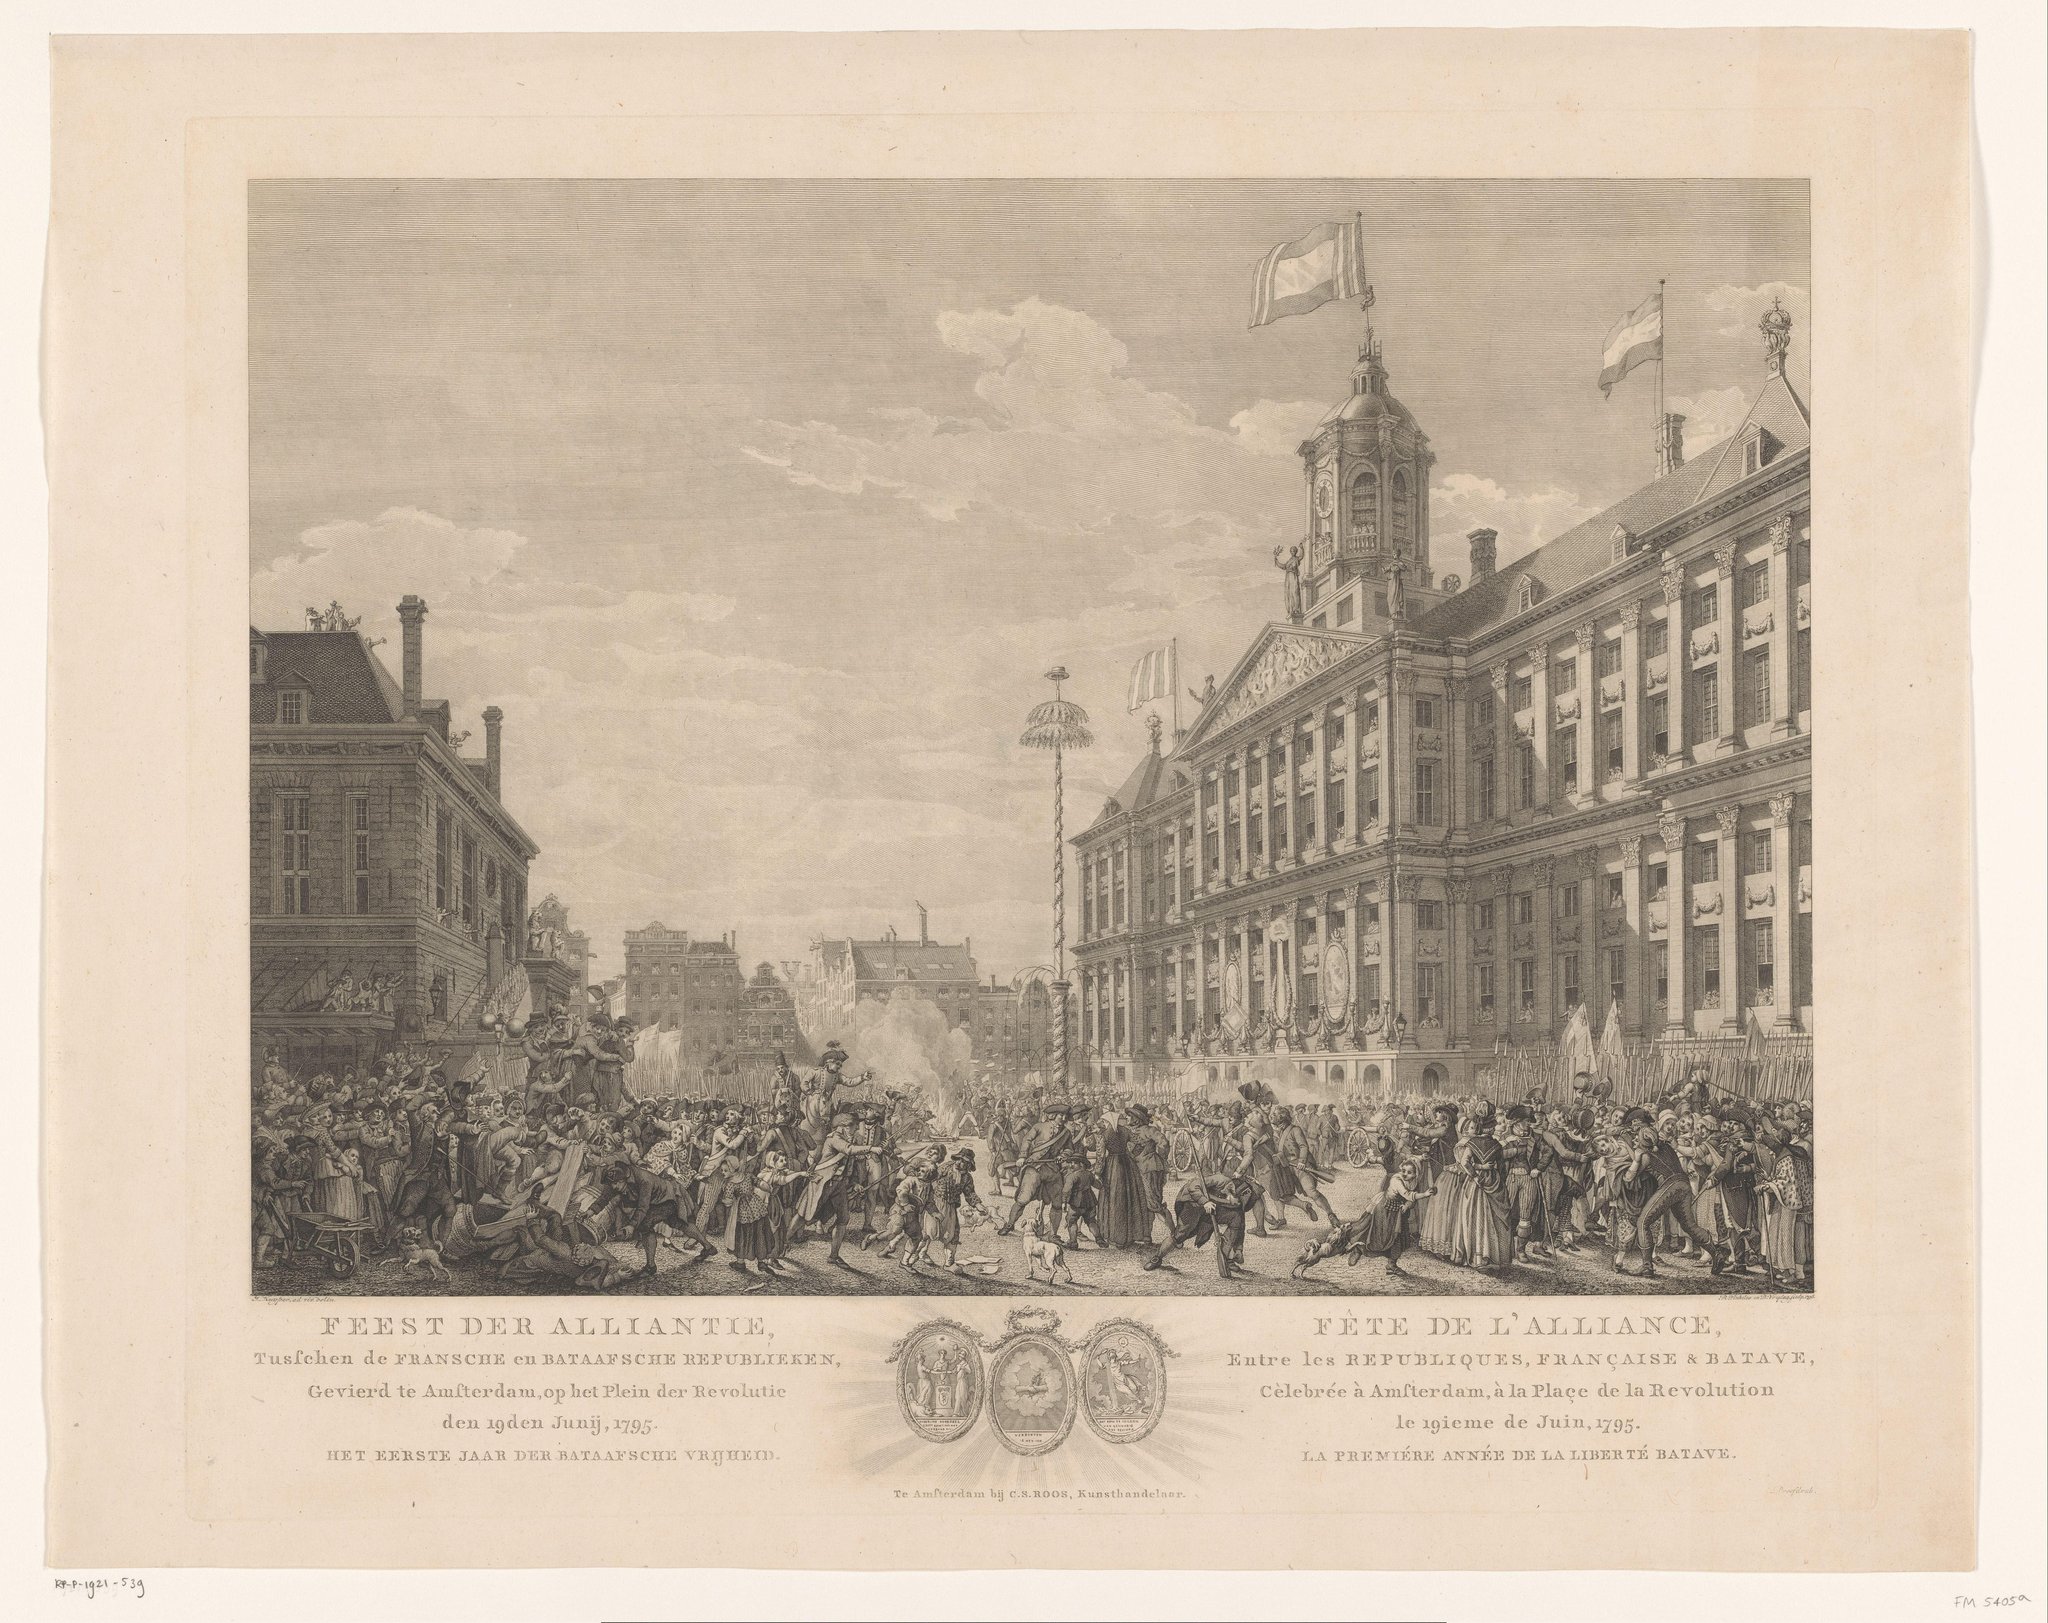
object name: print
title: Alliantiefeest op de Dam, 1795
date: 1796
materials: paper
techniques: etching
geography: amsterdam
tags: alliance, league, union, foedus, dancing around the tree of liberty, alliance with france (1795)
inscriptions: date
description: Het Alliantiefeest op de Dam voor het Stadhuis te Amsterdam, ter viering van de alliantie gesloten tussen de Franse en de Bataafse Republiek, 19 juni 1795. Chaotisch feestgewoel, centraal de vrijheidsboom. In het onderschrift de drie ovale medaillons met allegorische voorstellingen die op de gevel van het stadhuis hingen.